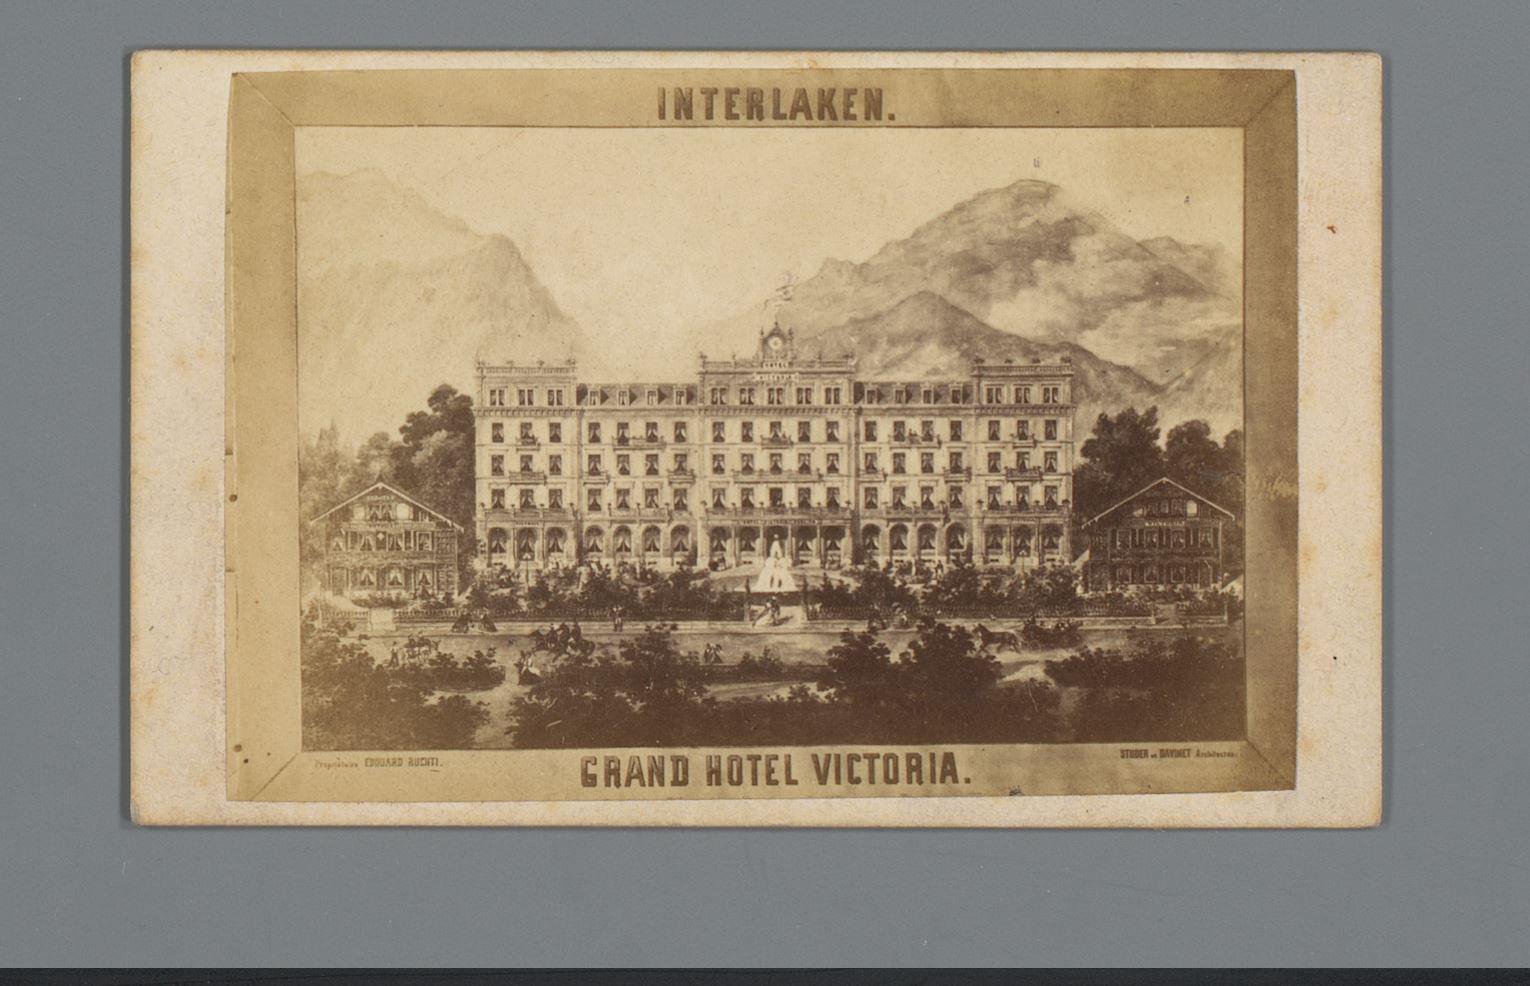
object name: carte de visite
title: Fotoreproductie van een tekening van het Grand Hotel Victoria te Interlaken, visitekaartje voor Grand Hotel Victoria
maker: Anonymous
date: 1870-1890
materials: paper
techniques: albumen print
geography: interlaken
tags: exterior ~ representation of a building, hotel, hostelry, inn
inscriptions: inscription: ‘GRAND HÔTEL VICTORIA/ INTERLAKEN/ Vis à vis la JUNGFRAU, au centre des Promenades. / PROPRIÉTAIRE/ ED. RUCHTI’